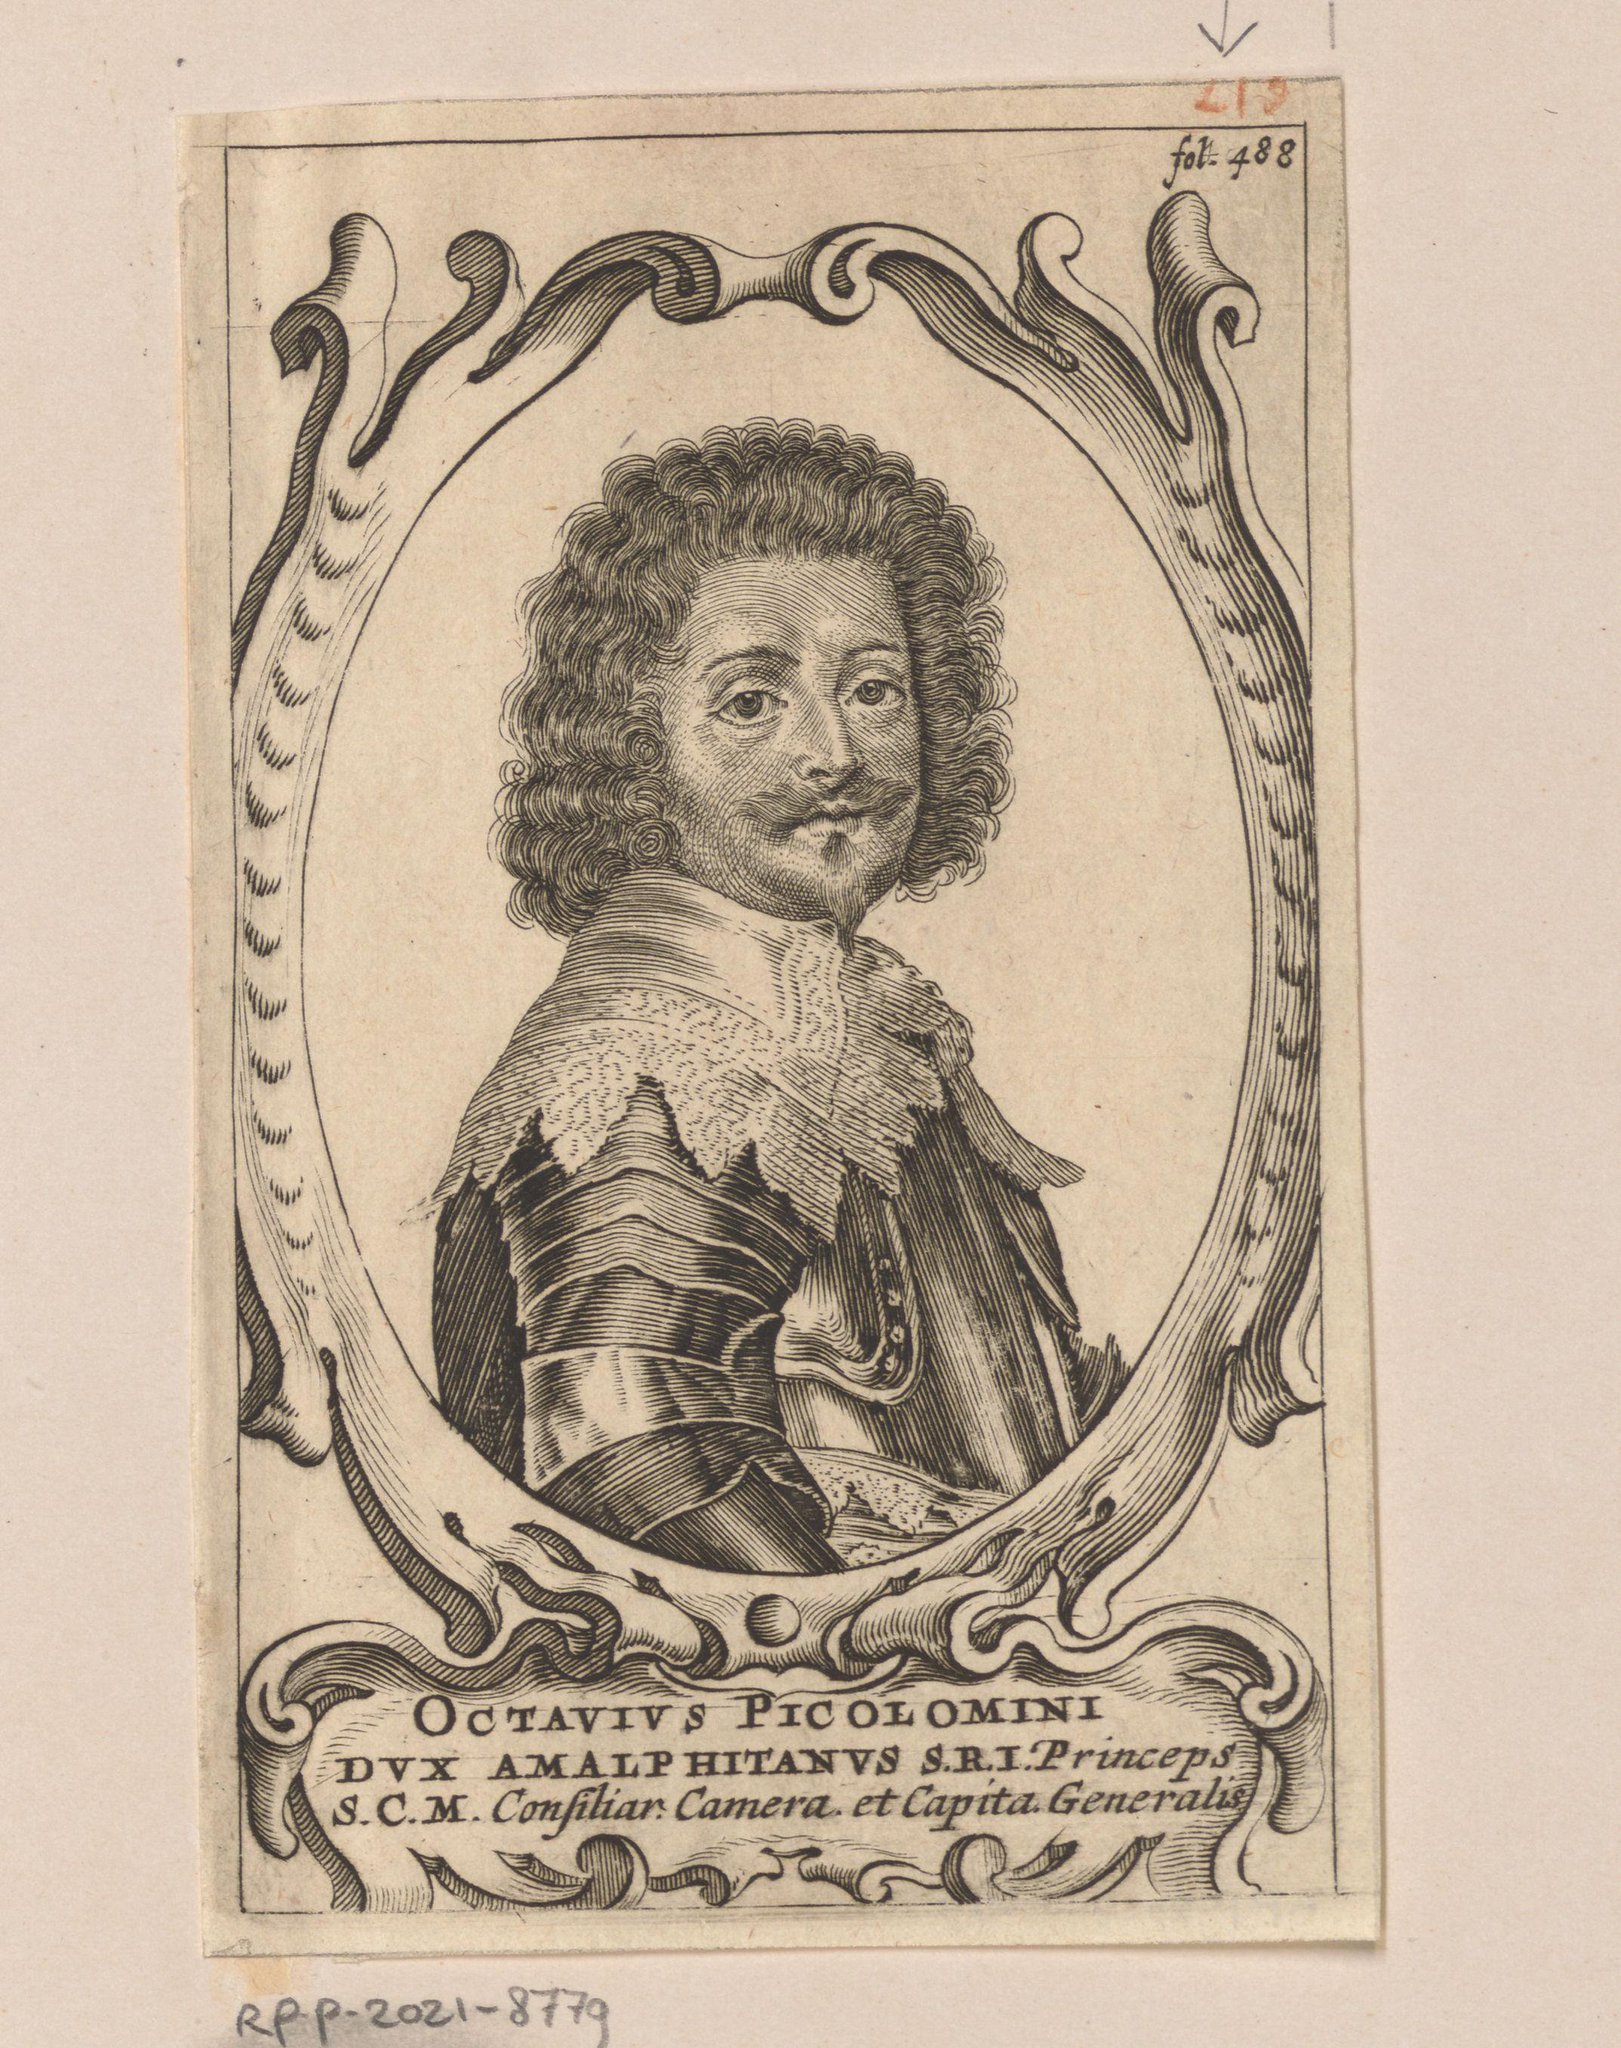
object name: print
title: Portret van Ottavio Piccolomini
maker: Anonymous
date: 1656-1666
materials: paper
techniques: engraving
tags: adult man, historical persons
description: Prent waarschijnlijk uit: Brachelius, Johannes Adolphus. Historia nostri temporis, dat is geschiedenis onses tijdts (…). Rotterdam: Andries van Hoogenhuysen, 1656. Of uit de editie van 1659 of 1666.